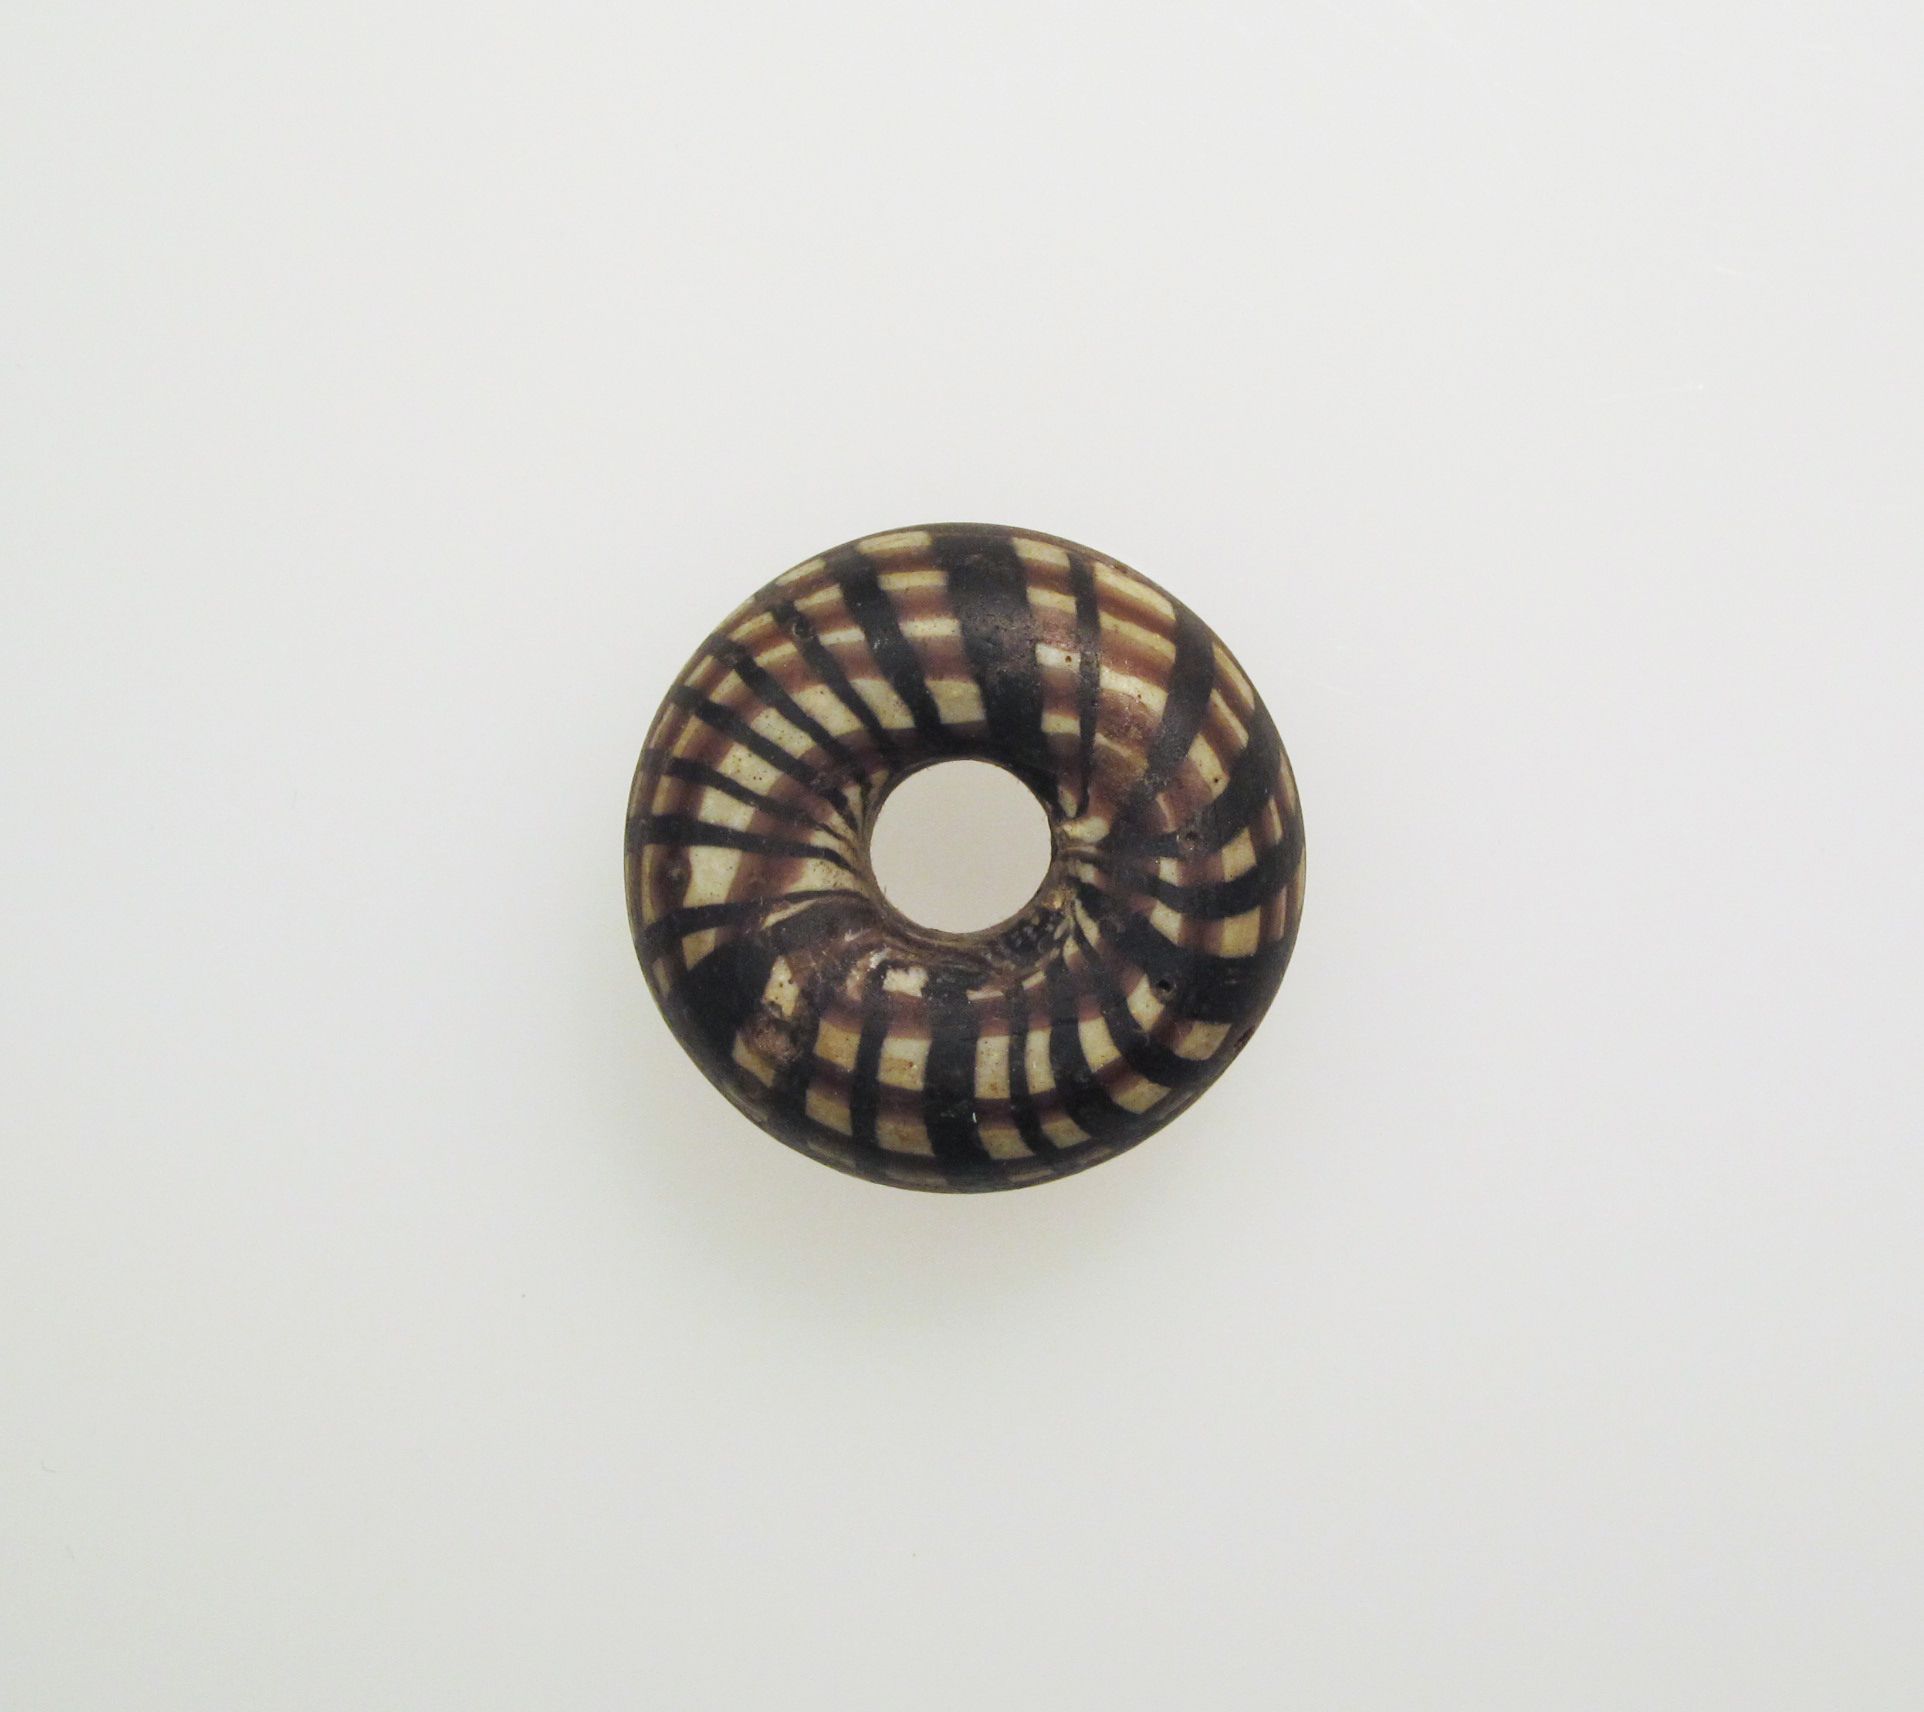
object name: bead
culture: roman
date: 670 BCE-330 CE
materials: glass